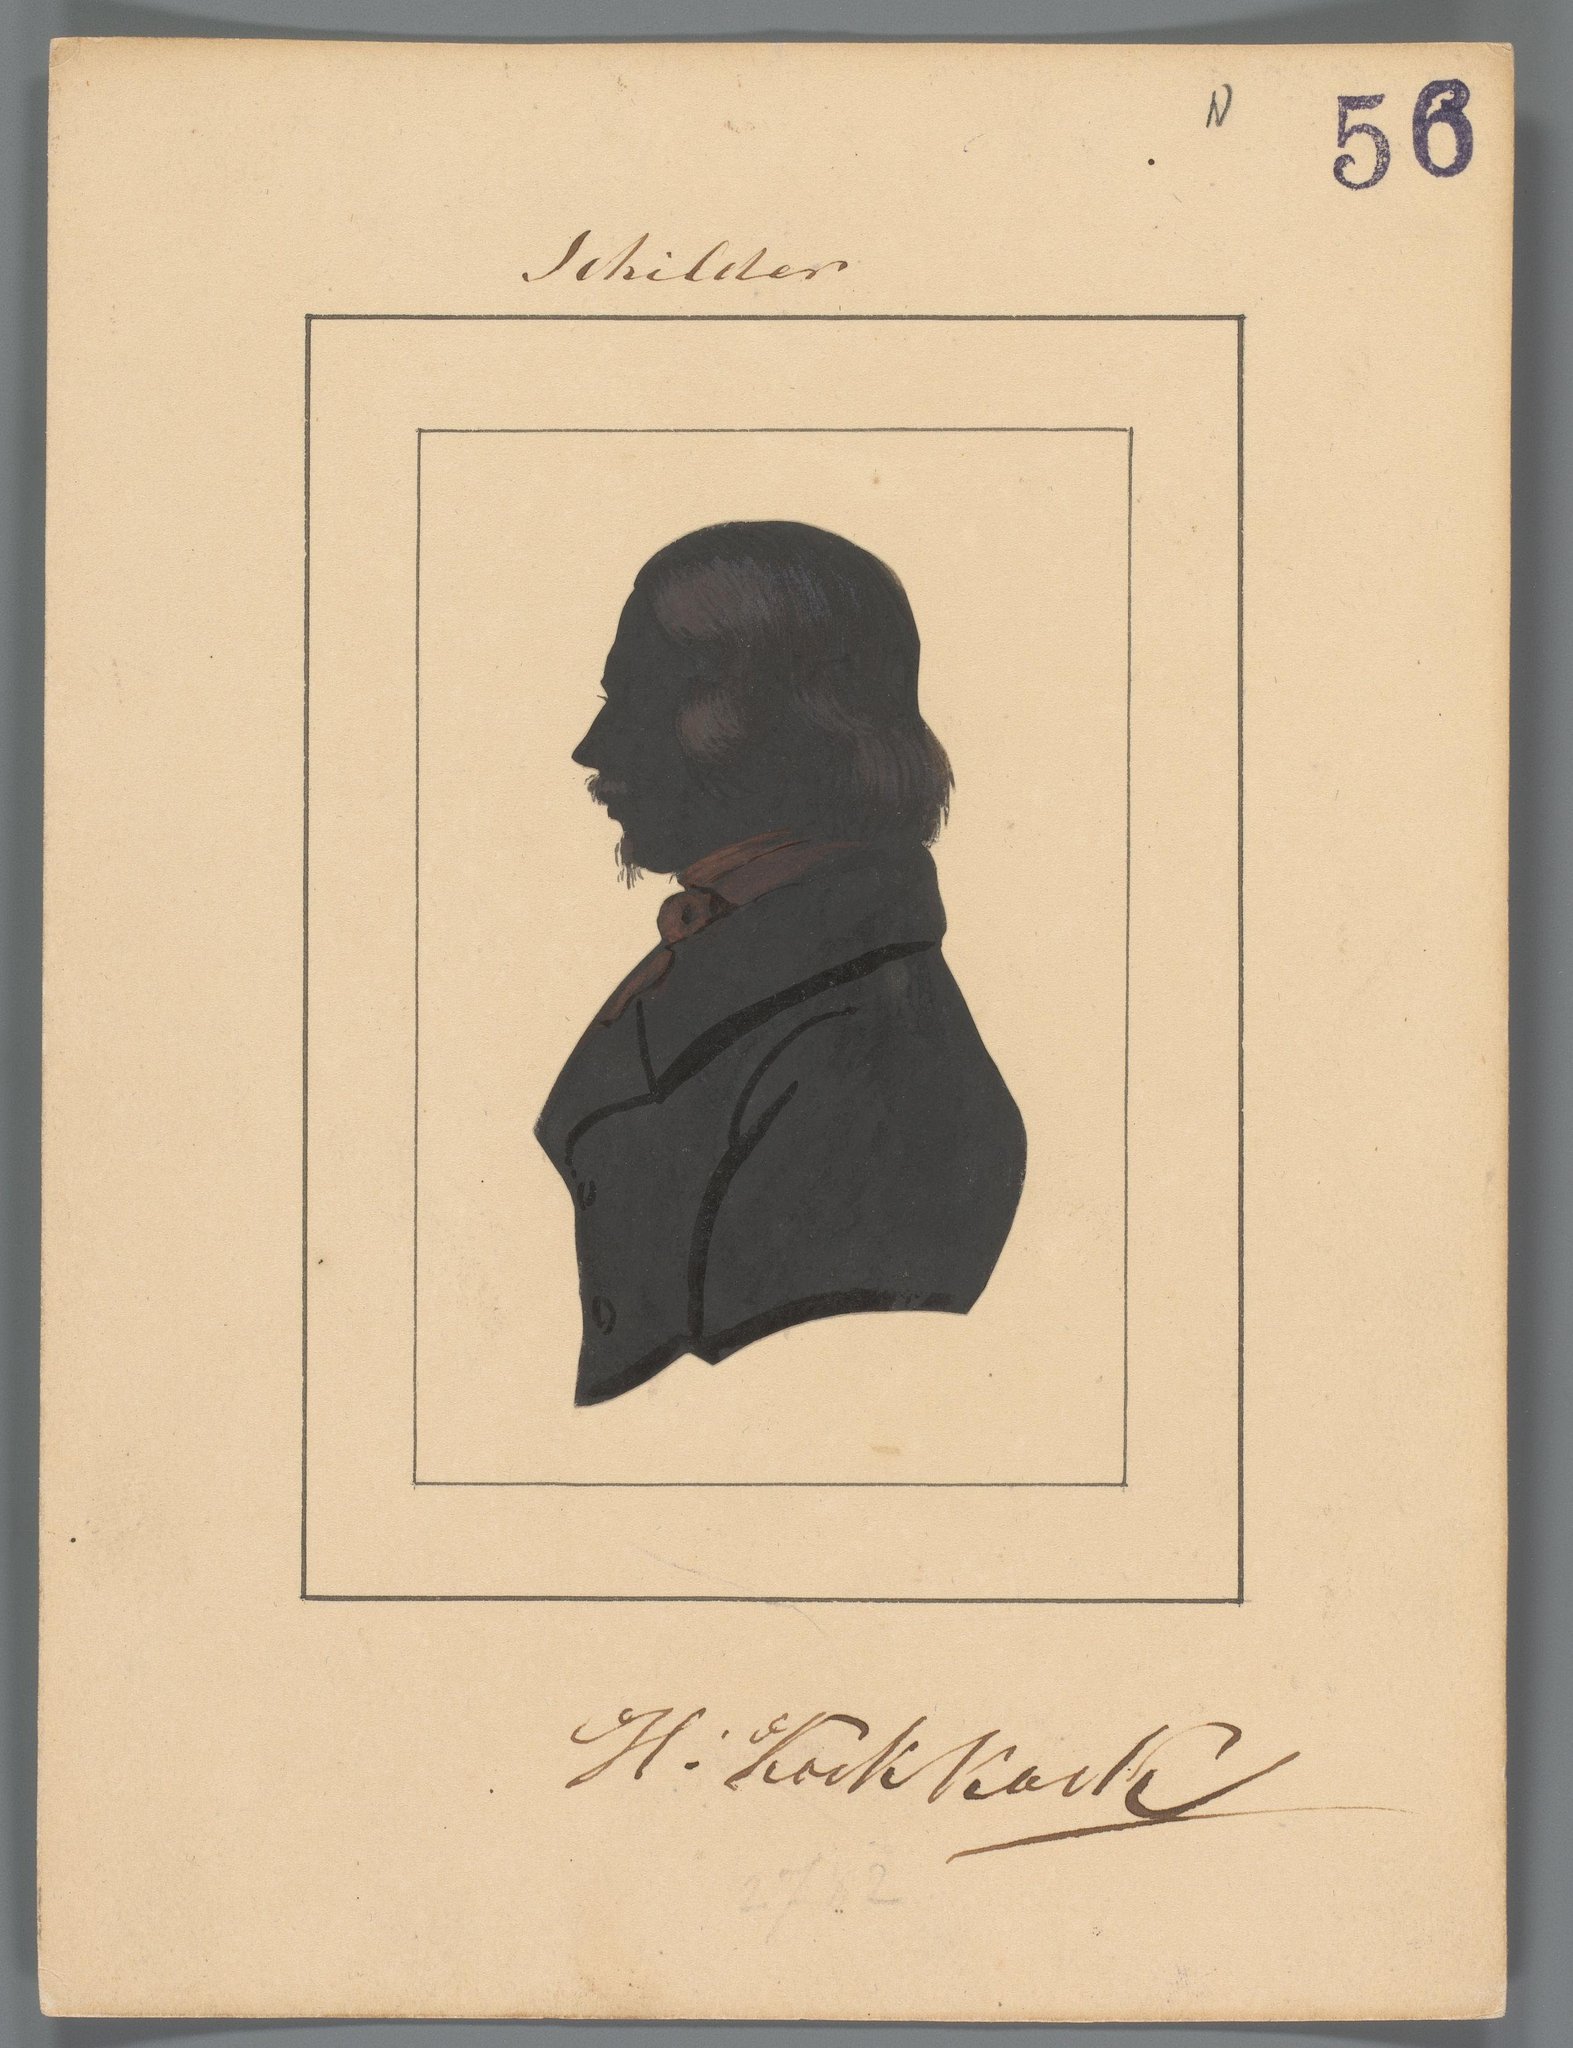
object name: drawing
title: Silhouetportret van Hermanus I Koekkoek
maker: elisabeth alida haanen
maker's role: draughtsman, print maker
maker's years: 1809-1845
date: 1819-1845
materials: ink, paint, paper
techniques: brush, snipping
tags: haarlem, painter, hermanus koekkoek (i), historical persons, portrait, self-portrait of painter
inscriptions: number: ‘14032’, collector's mark: ‘Ex-libris van Beresteyn’, number: ‘56’, inscription: ‘Schilder’, inscription: ‘C. 5154’, inscription: ‘H. Koekkoek’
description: Met onder het portret de handtekening van de geportretteerde.